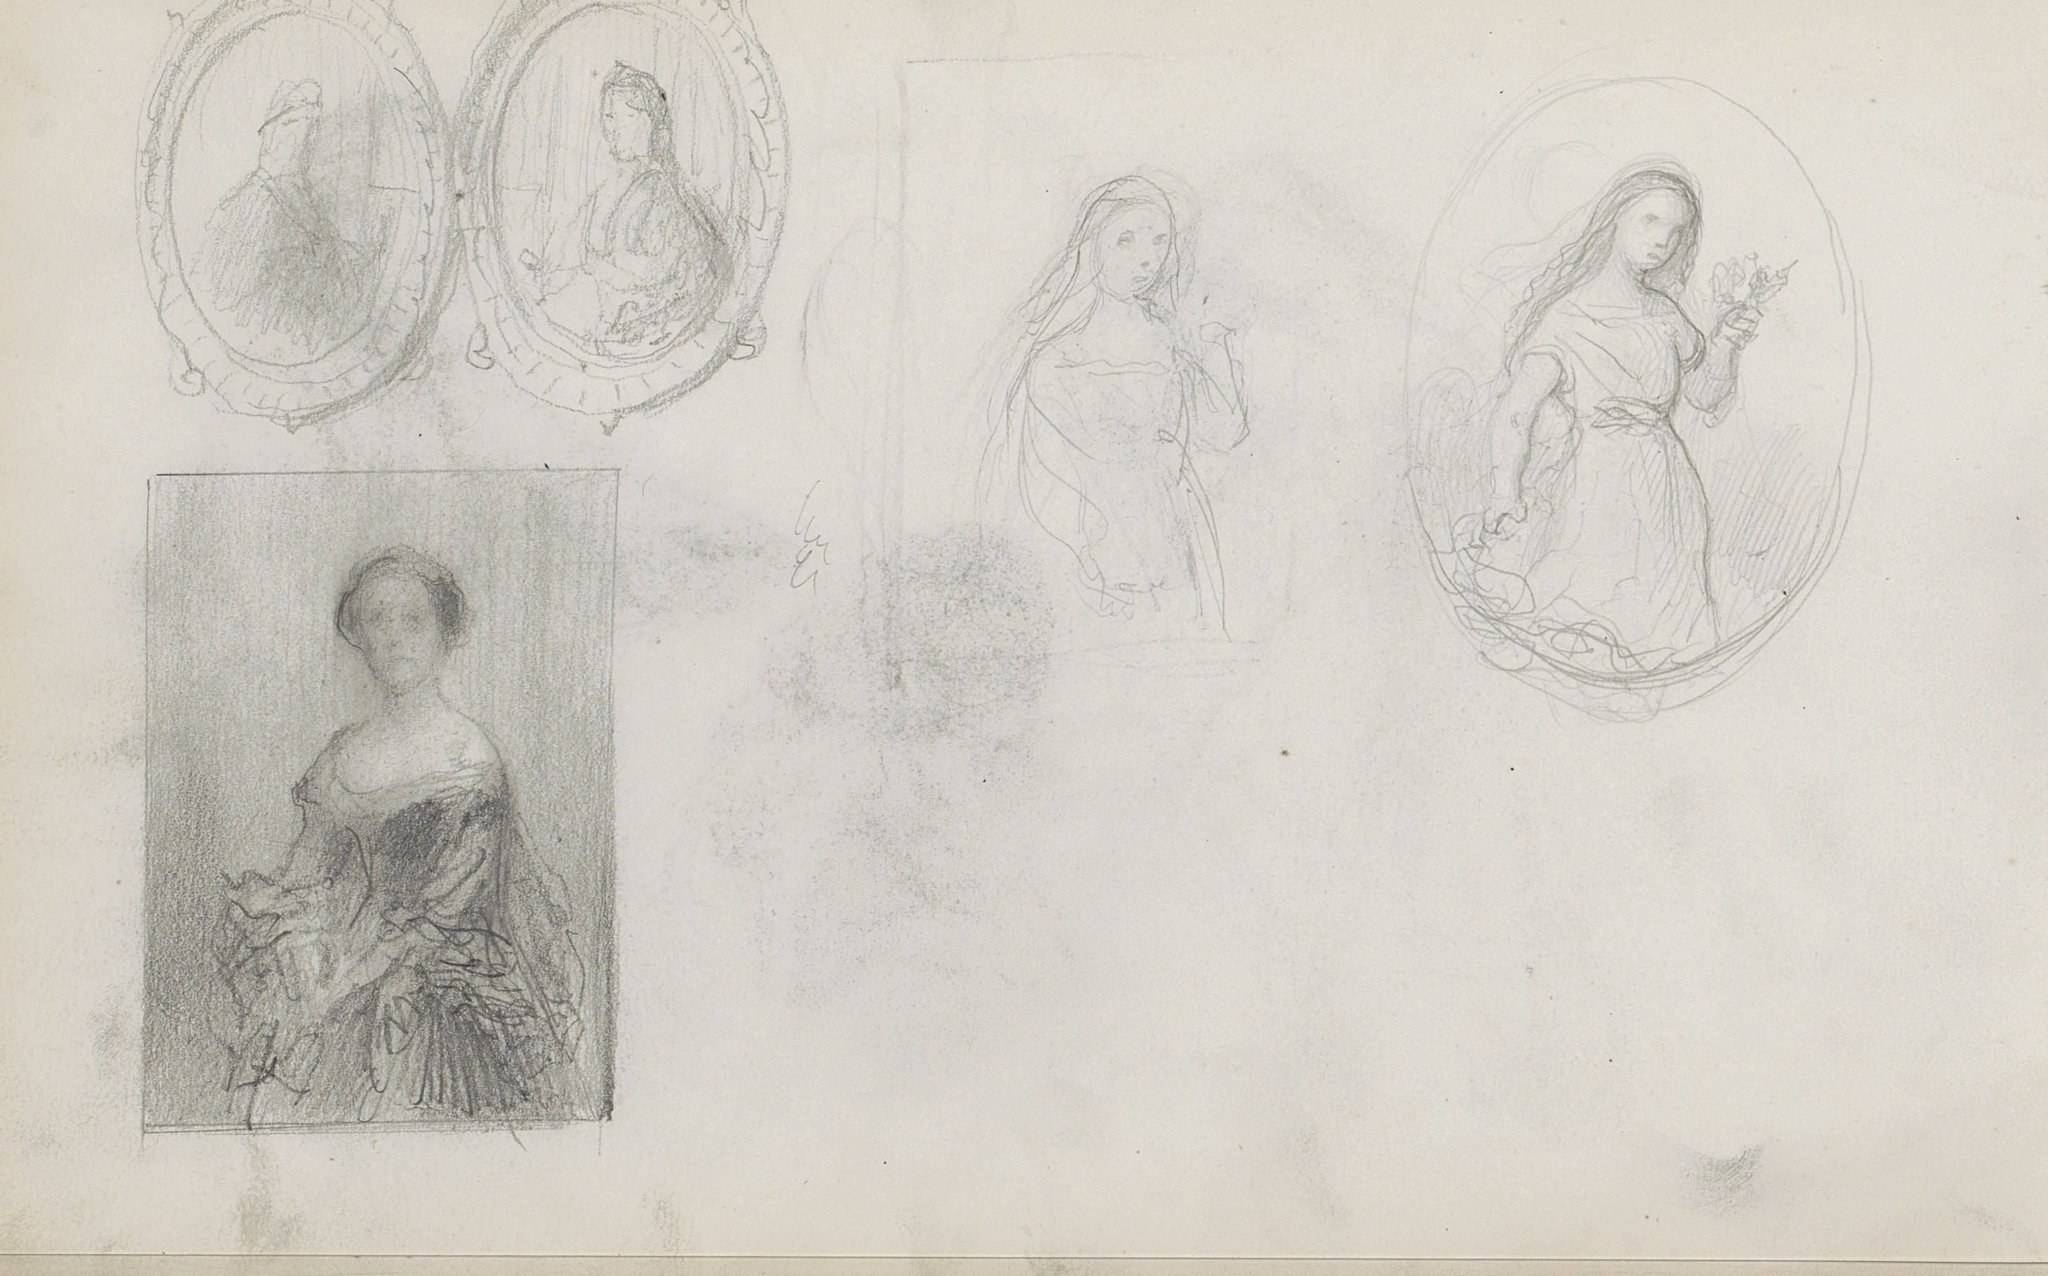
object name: sketchbook leaf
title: Portretten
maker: bastiaan de poorter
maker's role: painter, print maker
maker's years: 1813-1880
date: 1858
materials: paper, pencil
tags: anonymous historical person portrayed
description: Portretten van vrouwen, een man en meisjes in kaders, medaillons en een ovaal. Blad 21 verso uit een gecombineerd album amicorum en schetsboek met in totaal 39 bladen.